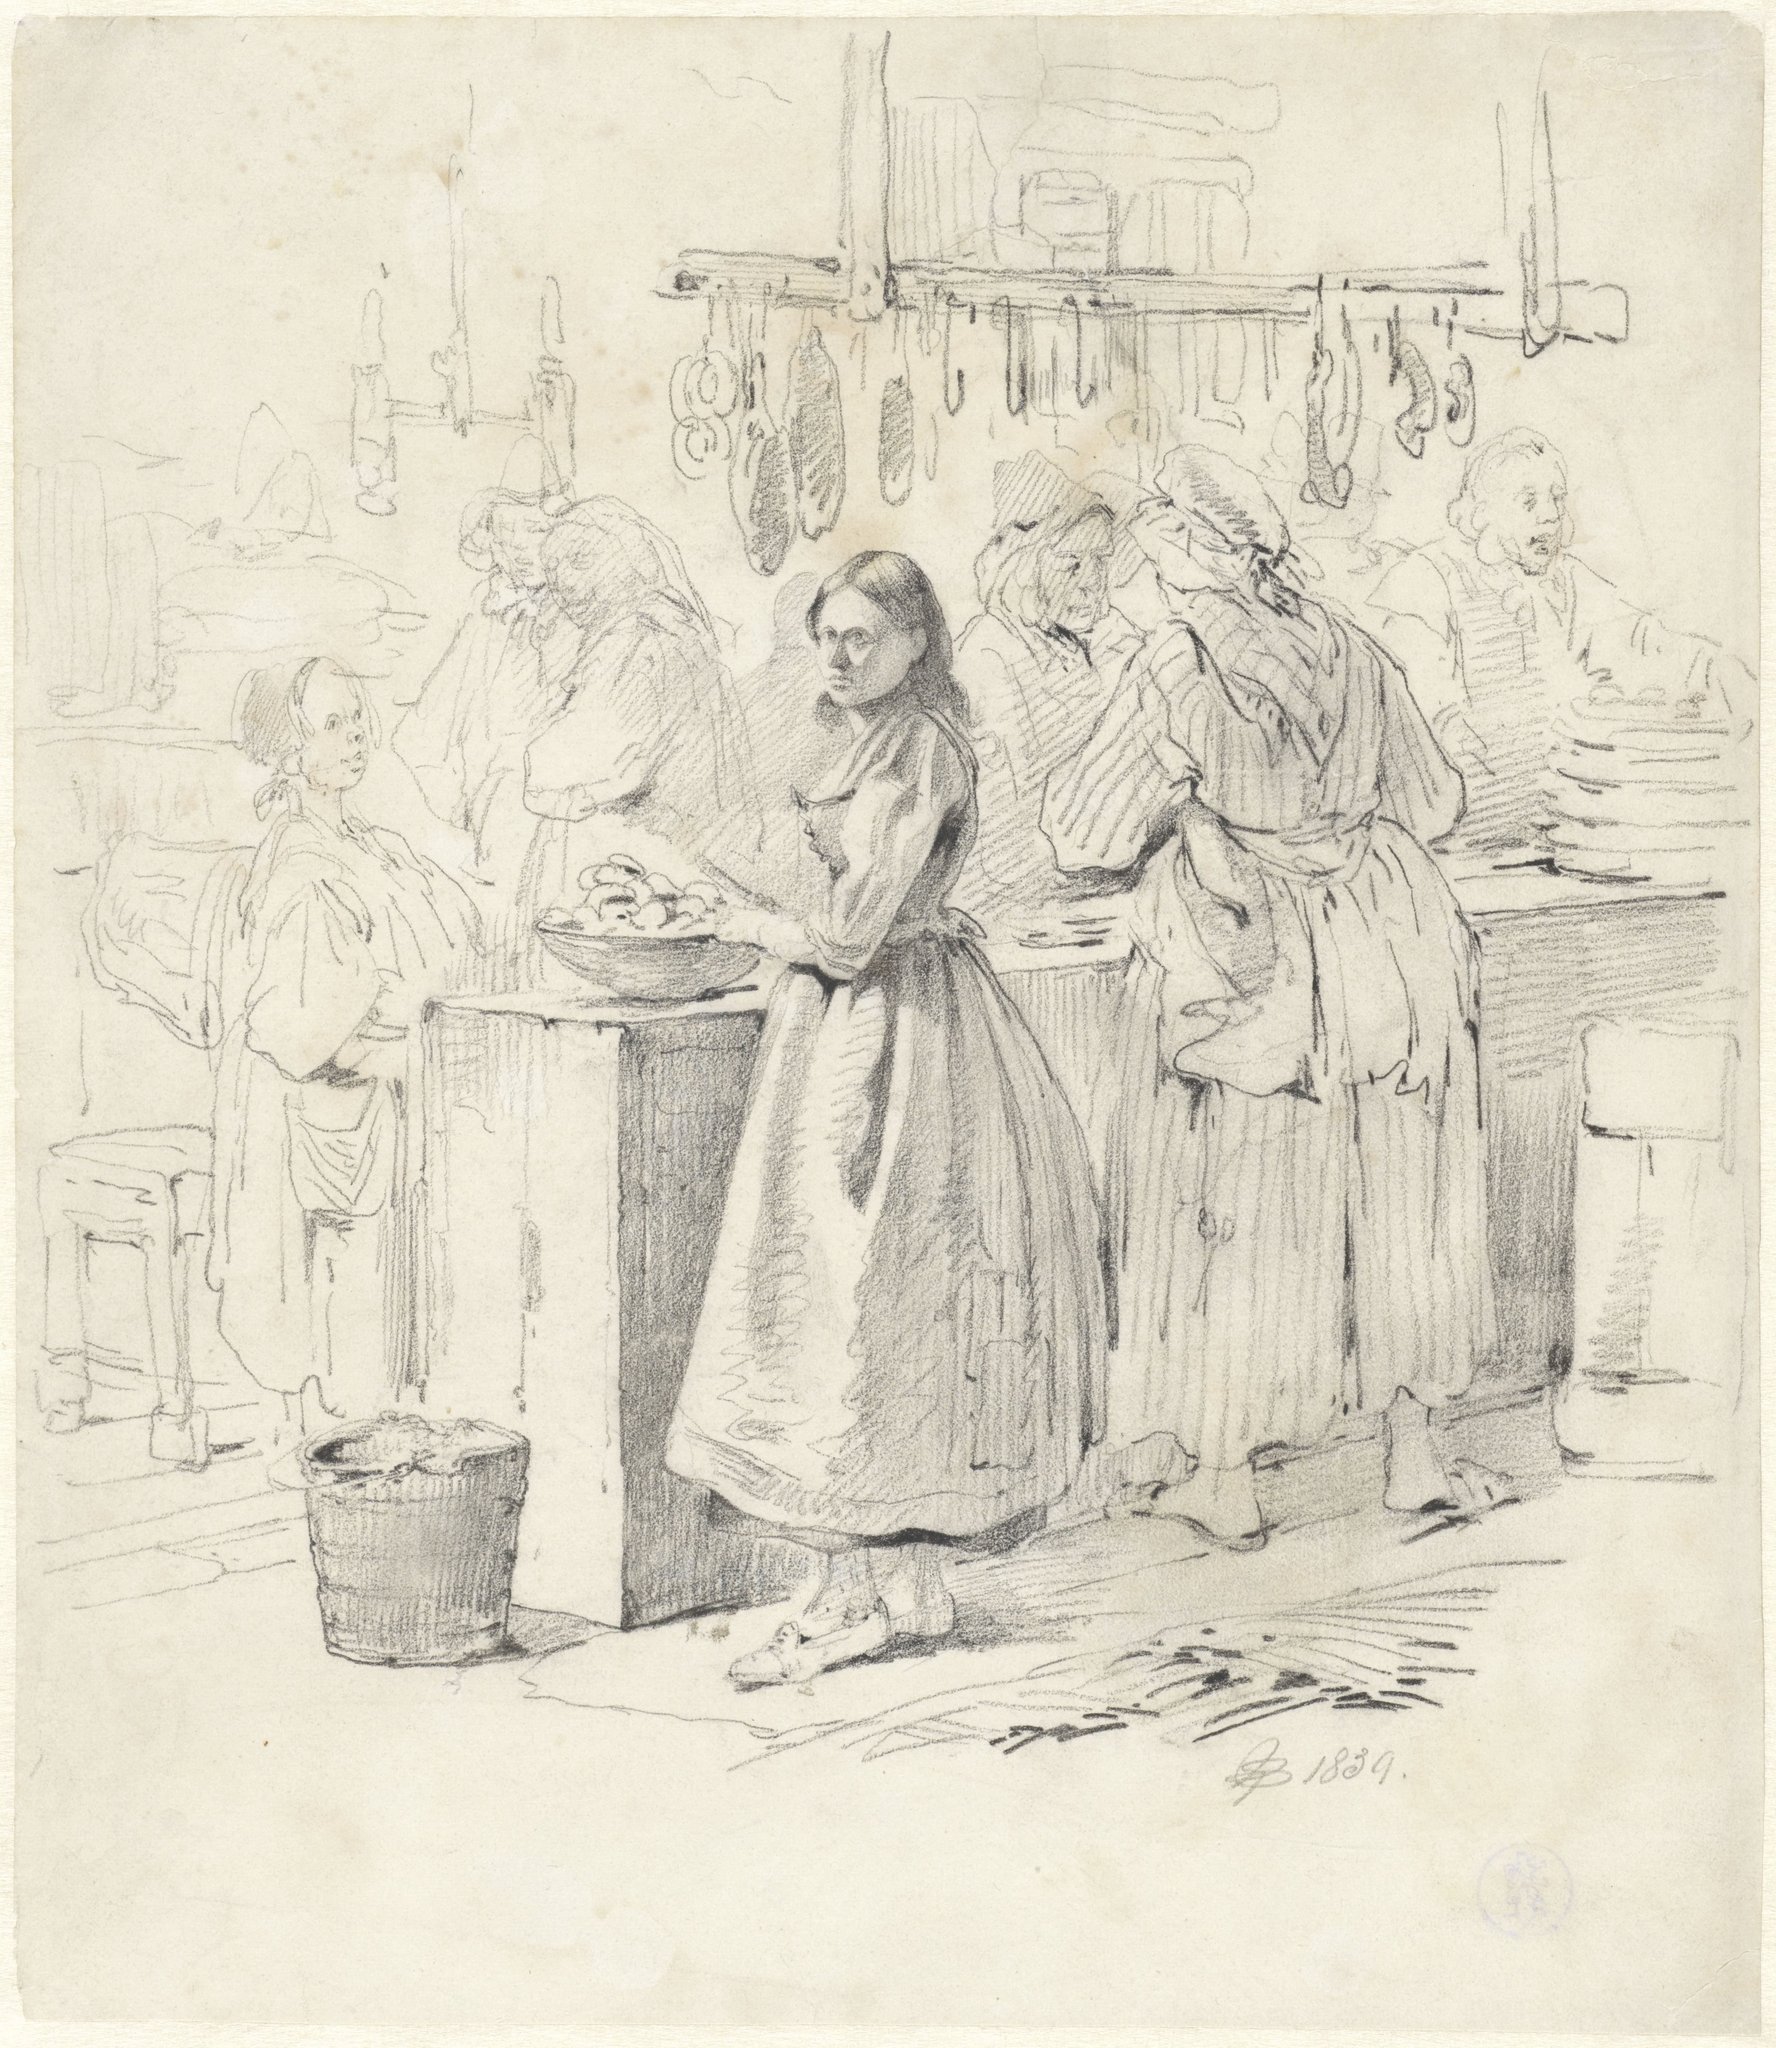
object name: drawing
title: Interieur van een slagerswinkel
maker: pieter van loon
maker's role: draughtsman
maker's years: 1801-1873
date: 1839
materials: paper, pencil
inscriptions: signature and date: ‘1839’